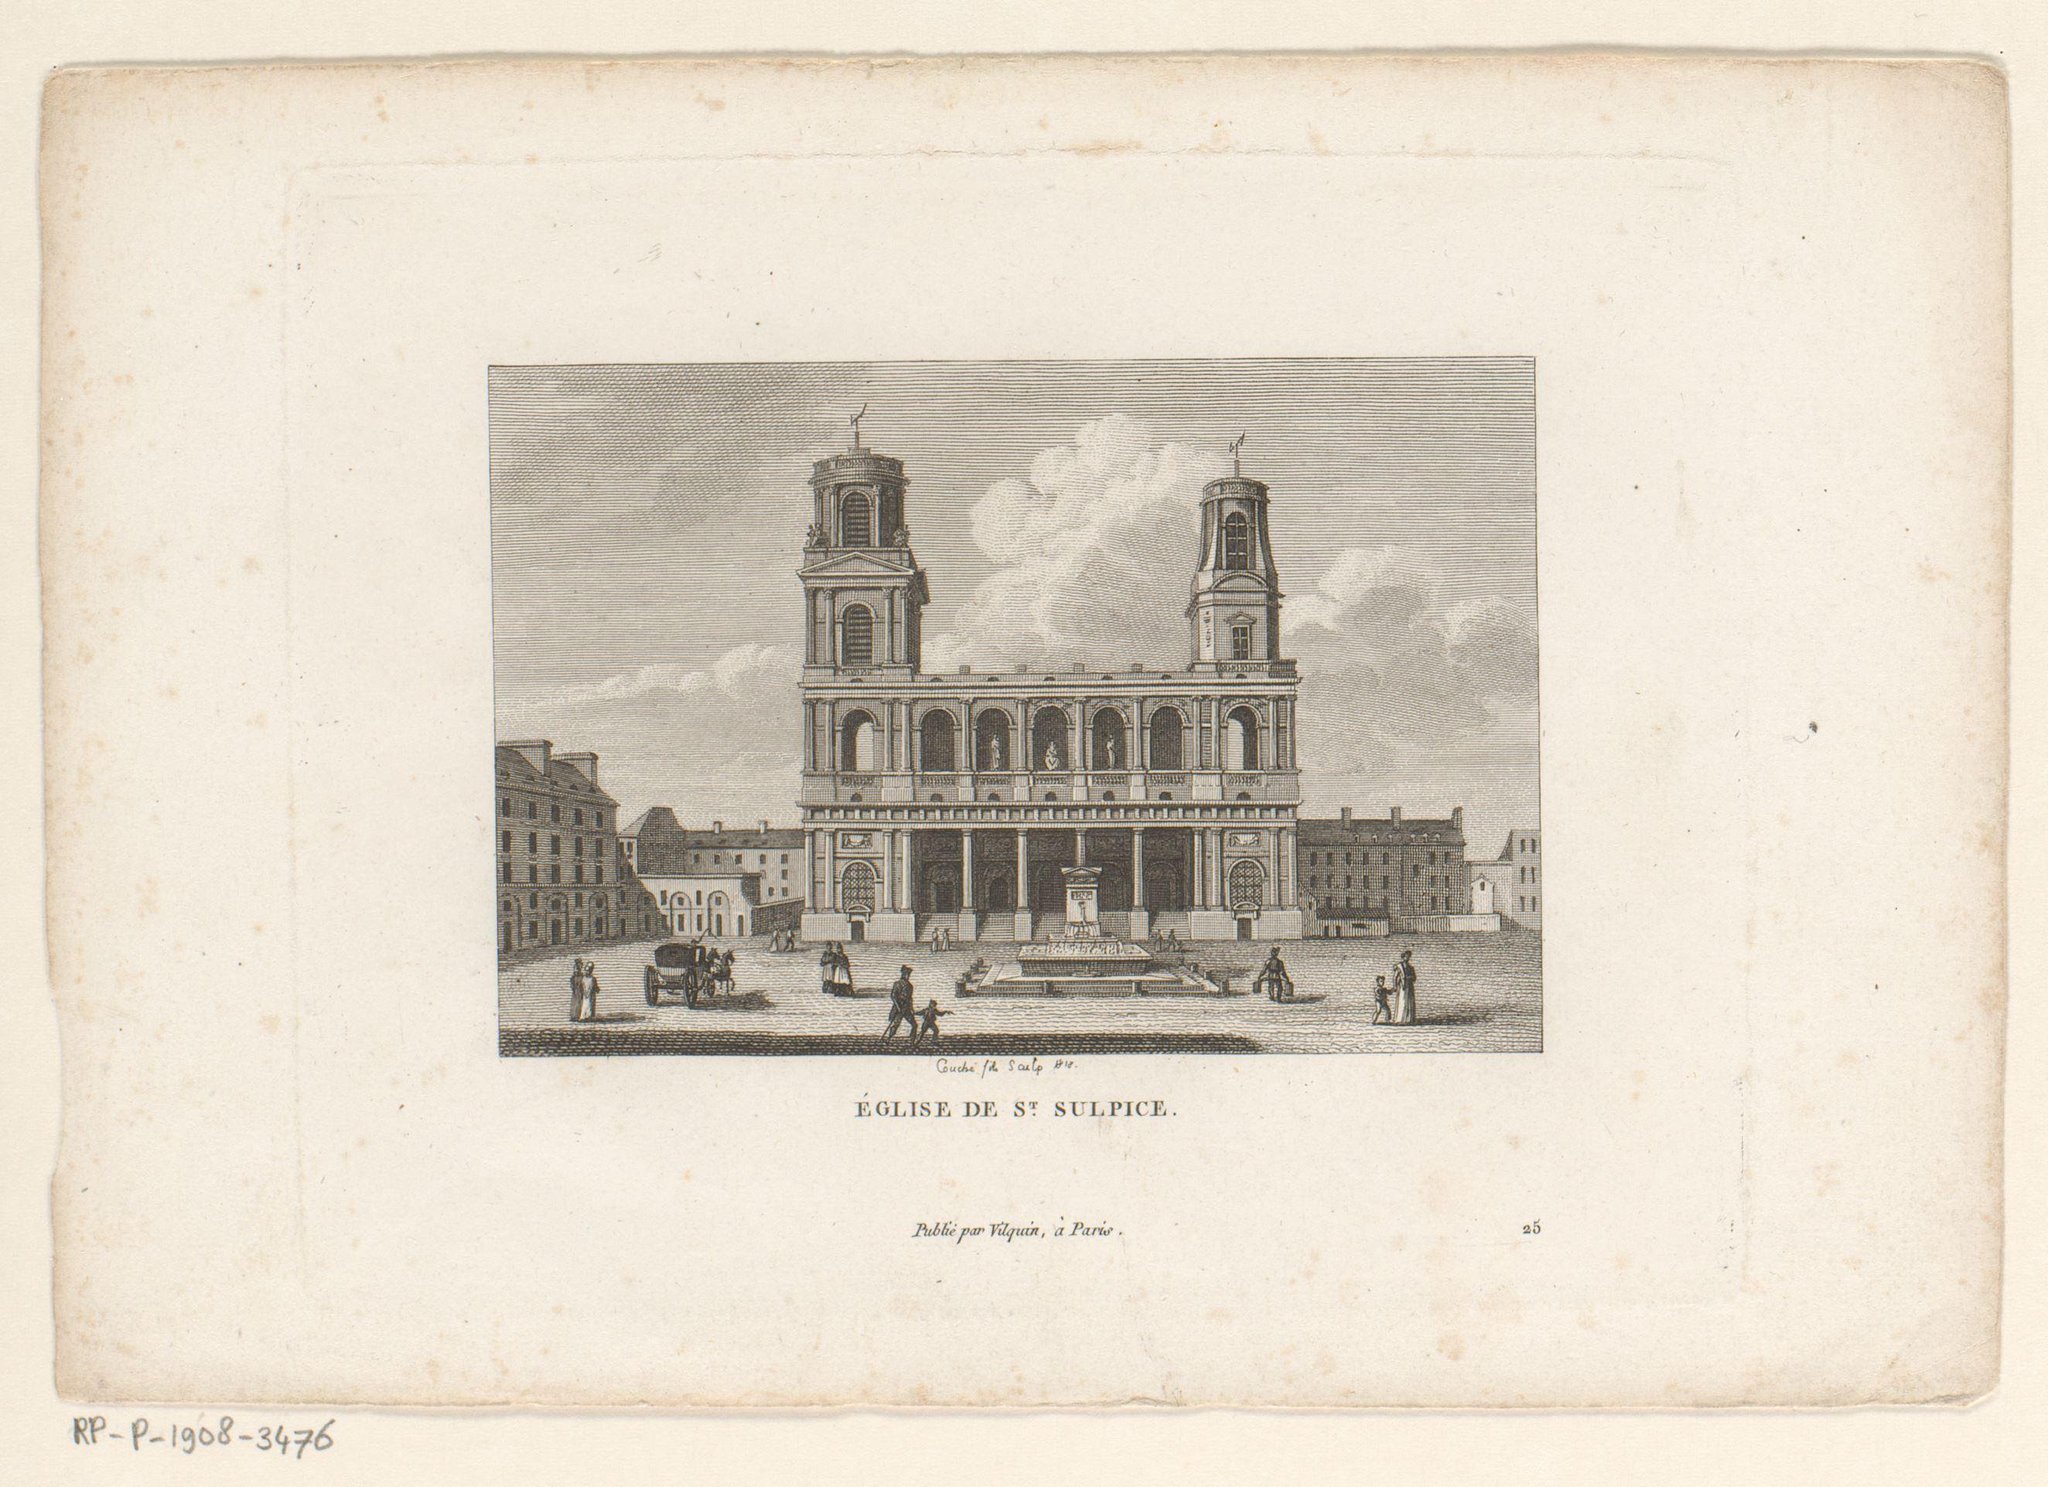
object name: print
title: Gezicht op de Église Saint-Sulpice te Parijs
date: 1818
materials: paper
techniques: etching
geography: paris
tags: city-view in general; 'veduta', paris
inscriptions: collector's mark: Lugt 2228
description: Maakt deel uit van een serie met 60 platen van monumenten, kathedralen en paleizen in Parijs.